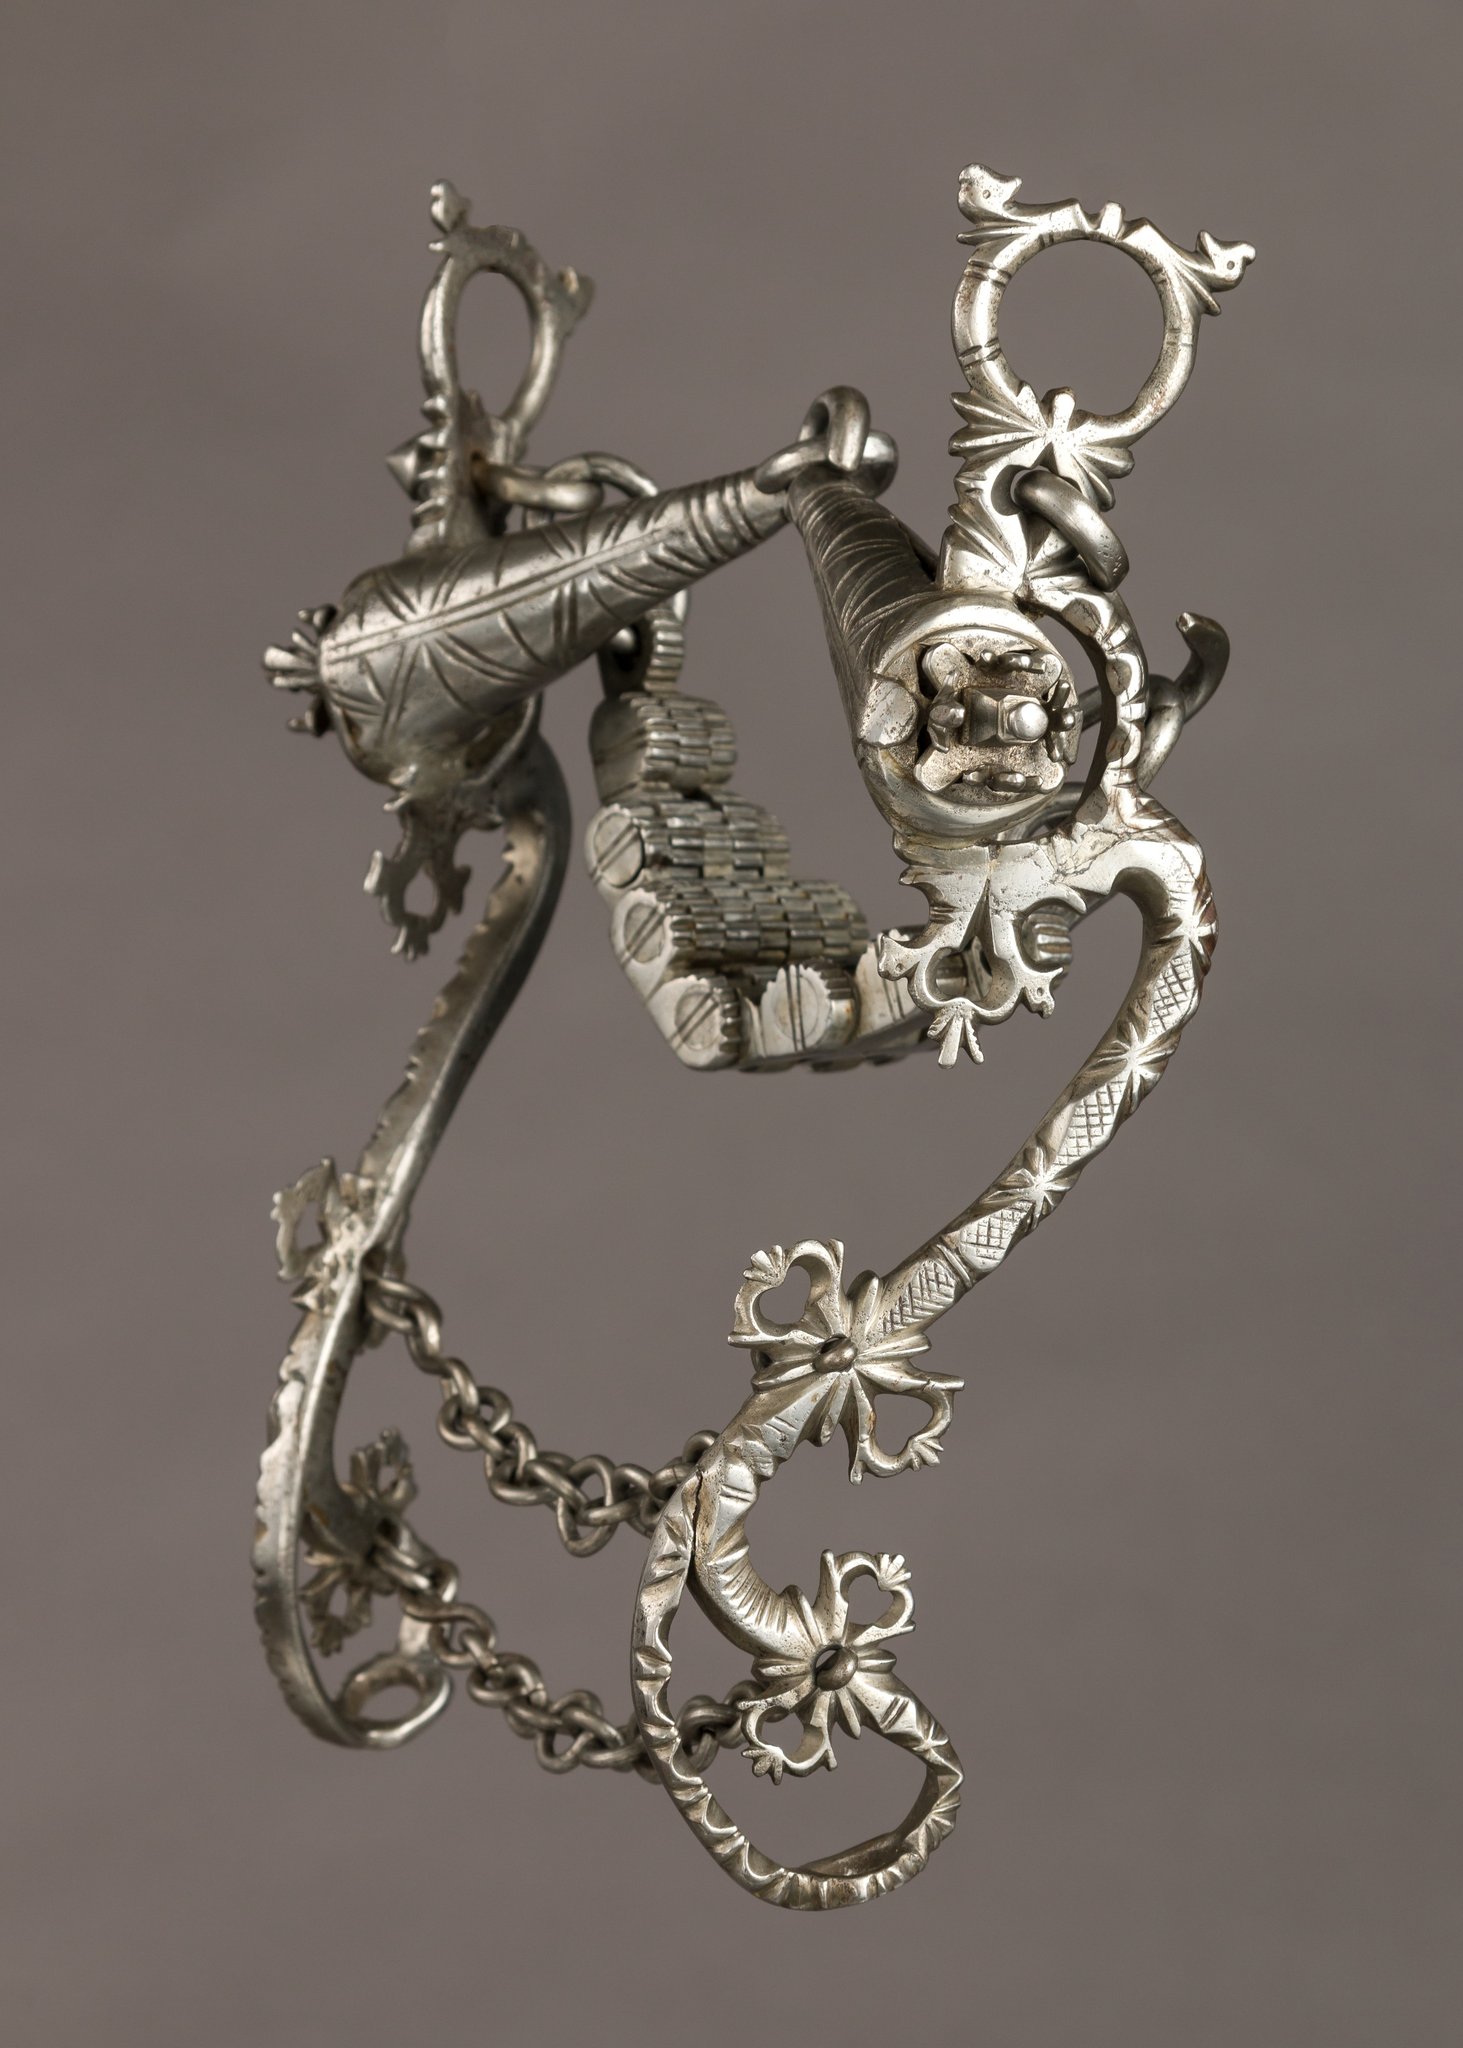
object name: bit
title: Curb Bit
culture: german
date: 1601-1700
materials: metal alloy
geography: germany